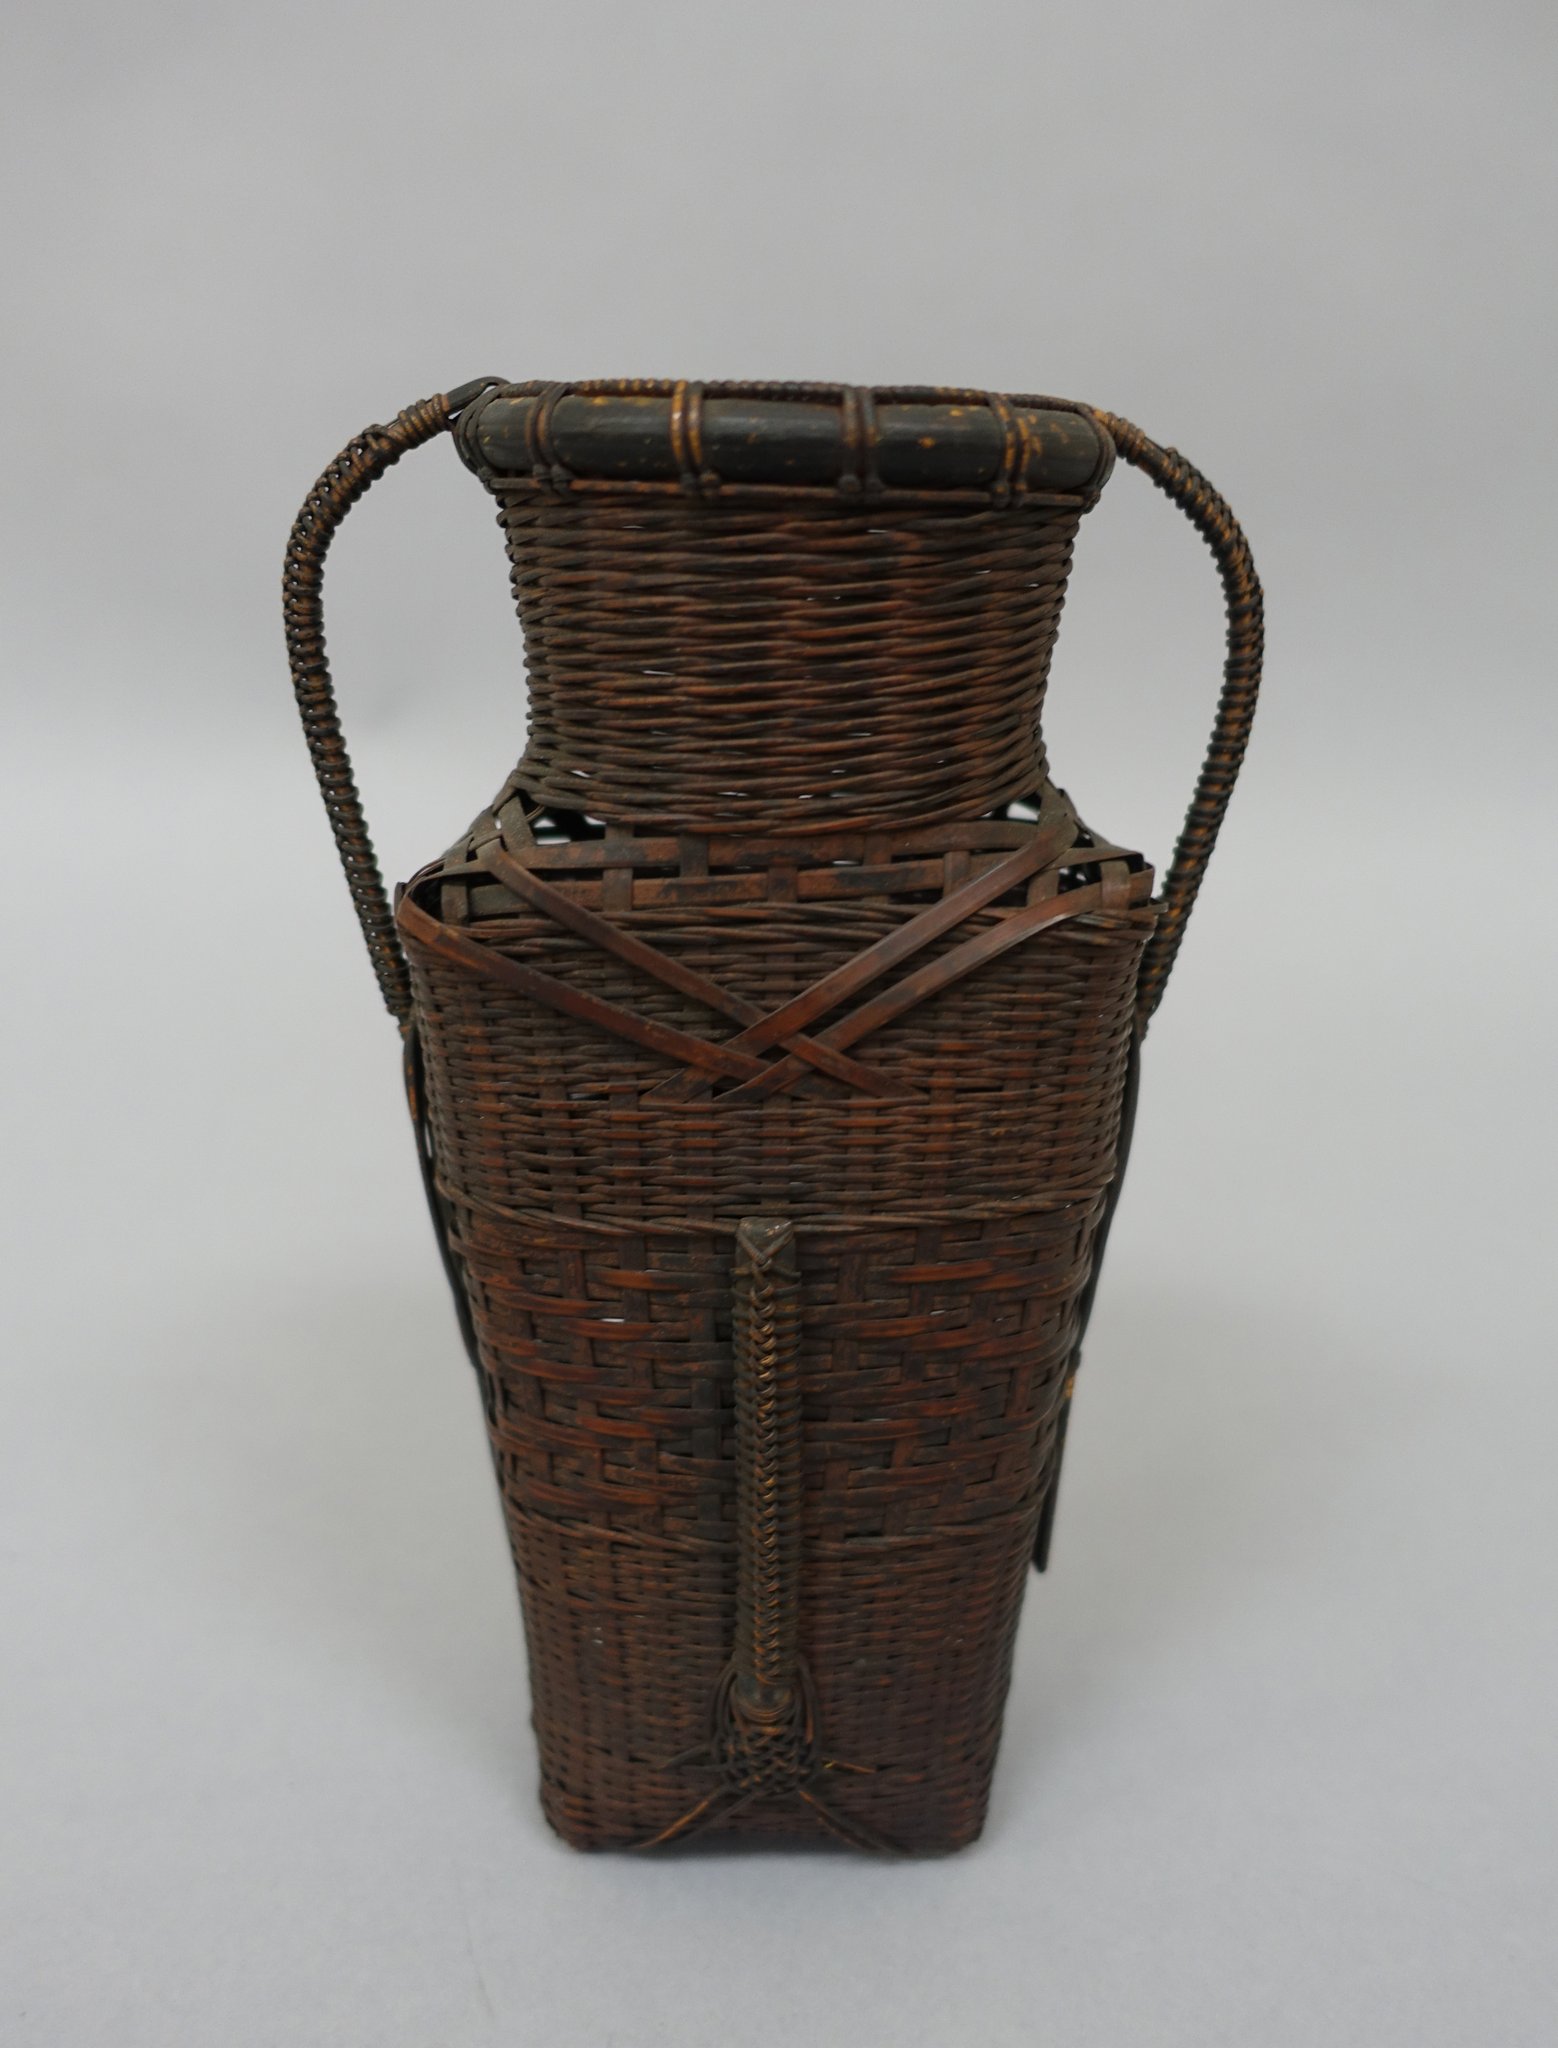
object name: hanging basket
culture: japanese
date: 1801-1900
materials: bamboo, rattan